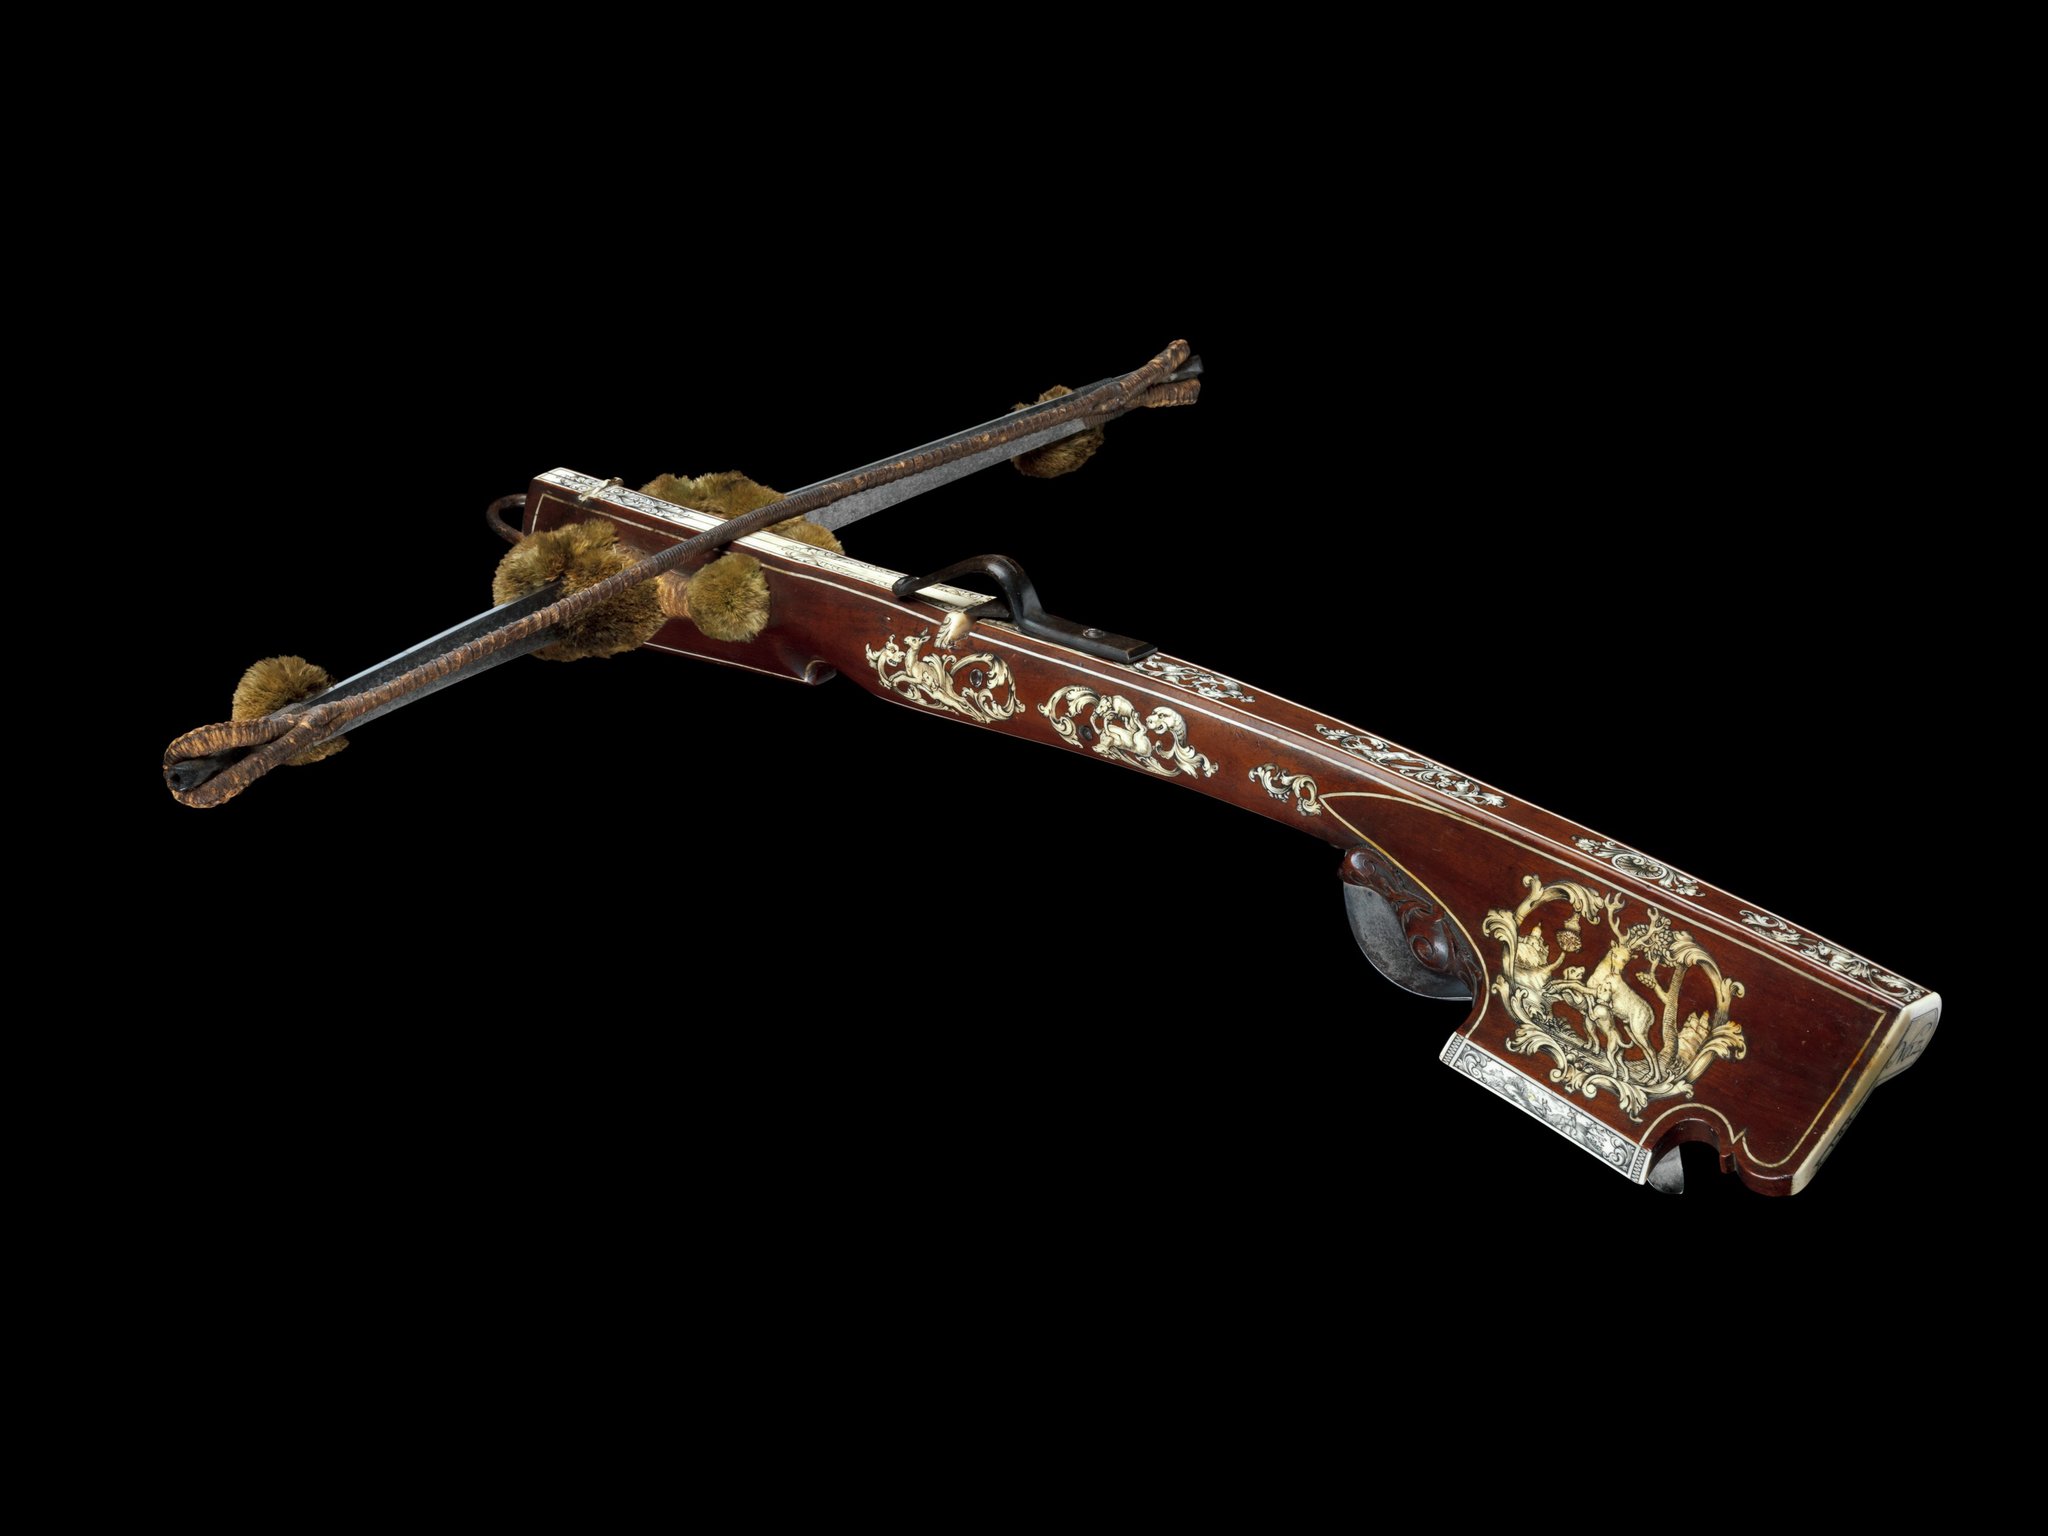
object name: small crossbow schnepper, for a woman or child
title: Small Crossbow (Schnepper), Probably for a Woman or Child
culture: german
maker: johann gottfried hänisch the elder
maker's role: maker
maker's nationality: german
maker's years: 1696-1778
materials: gold, hemp, horn, steel, wood, wool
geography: germany